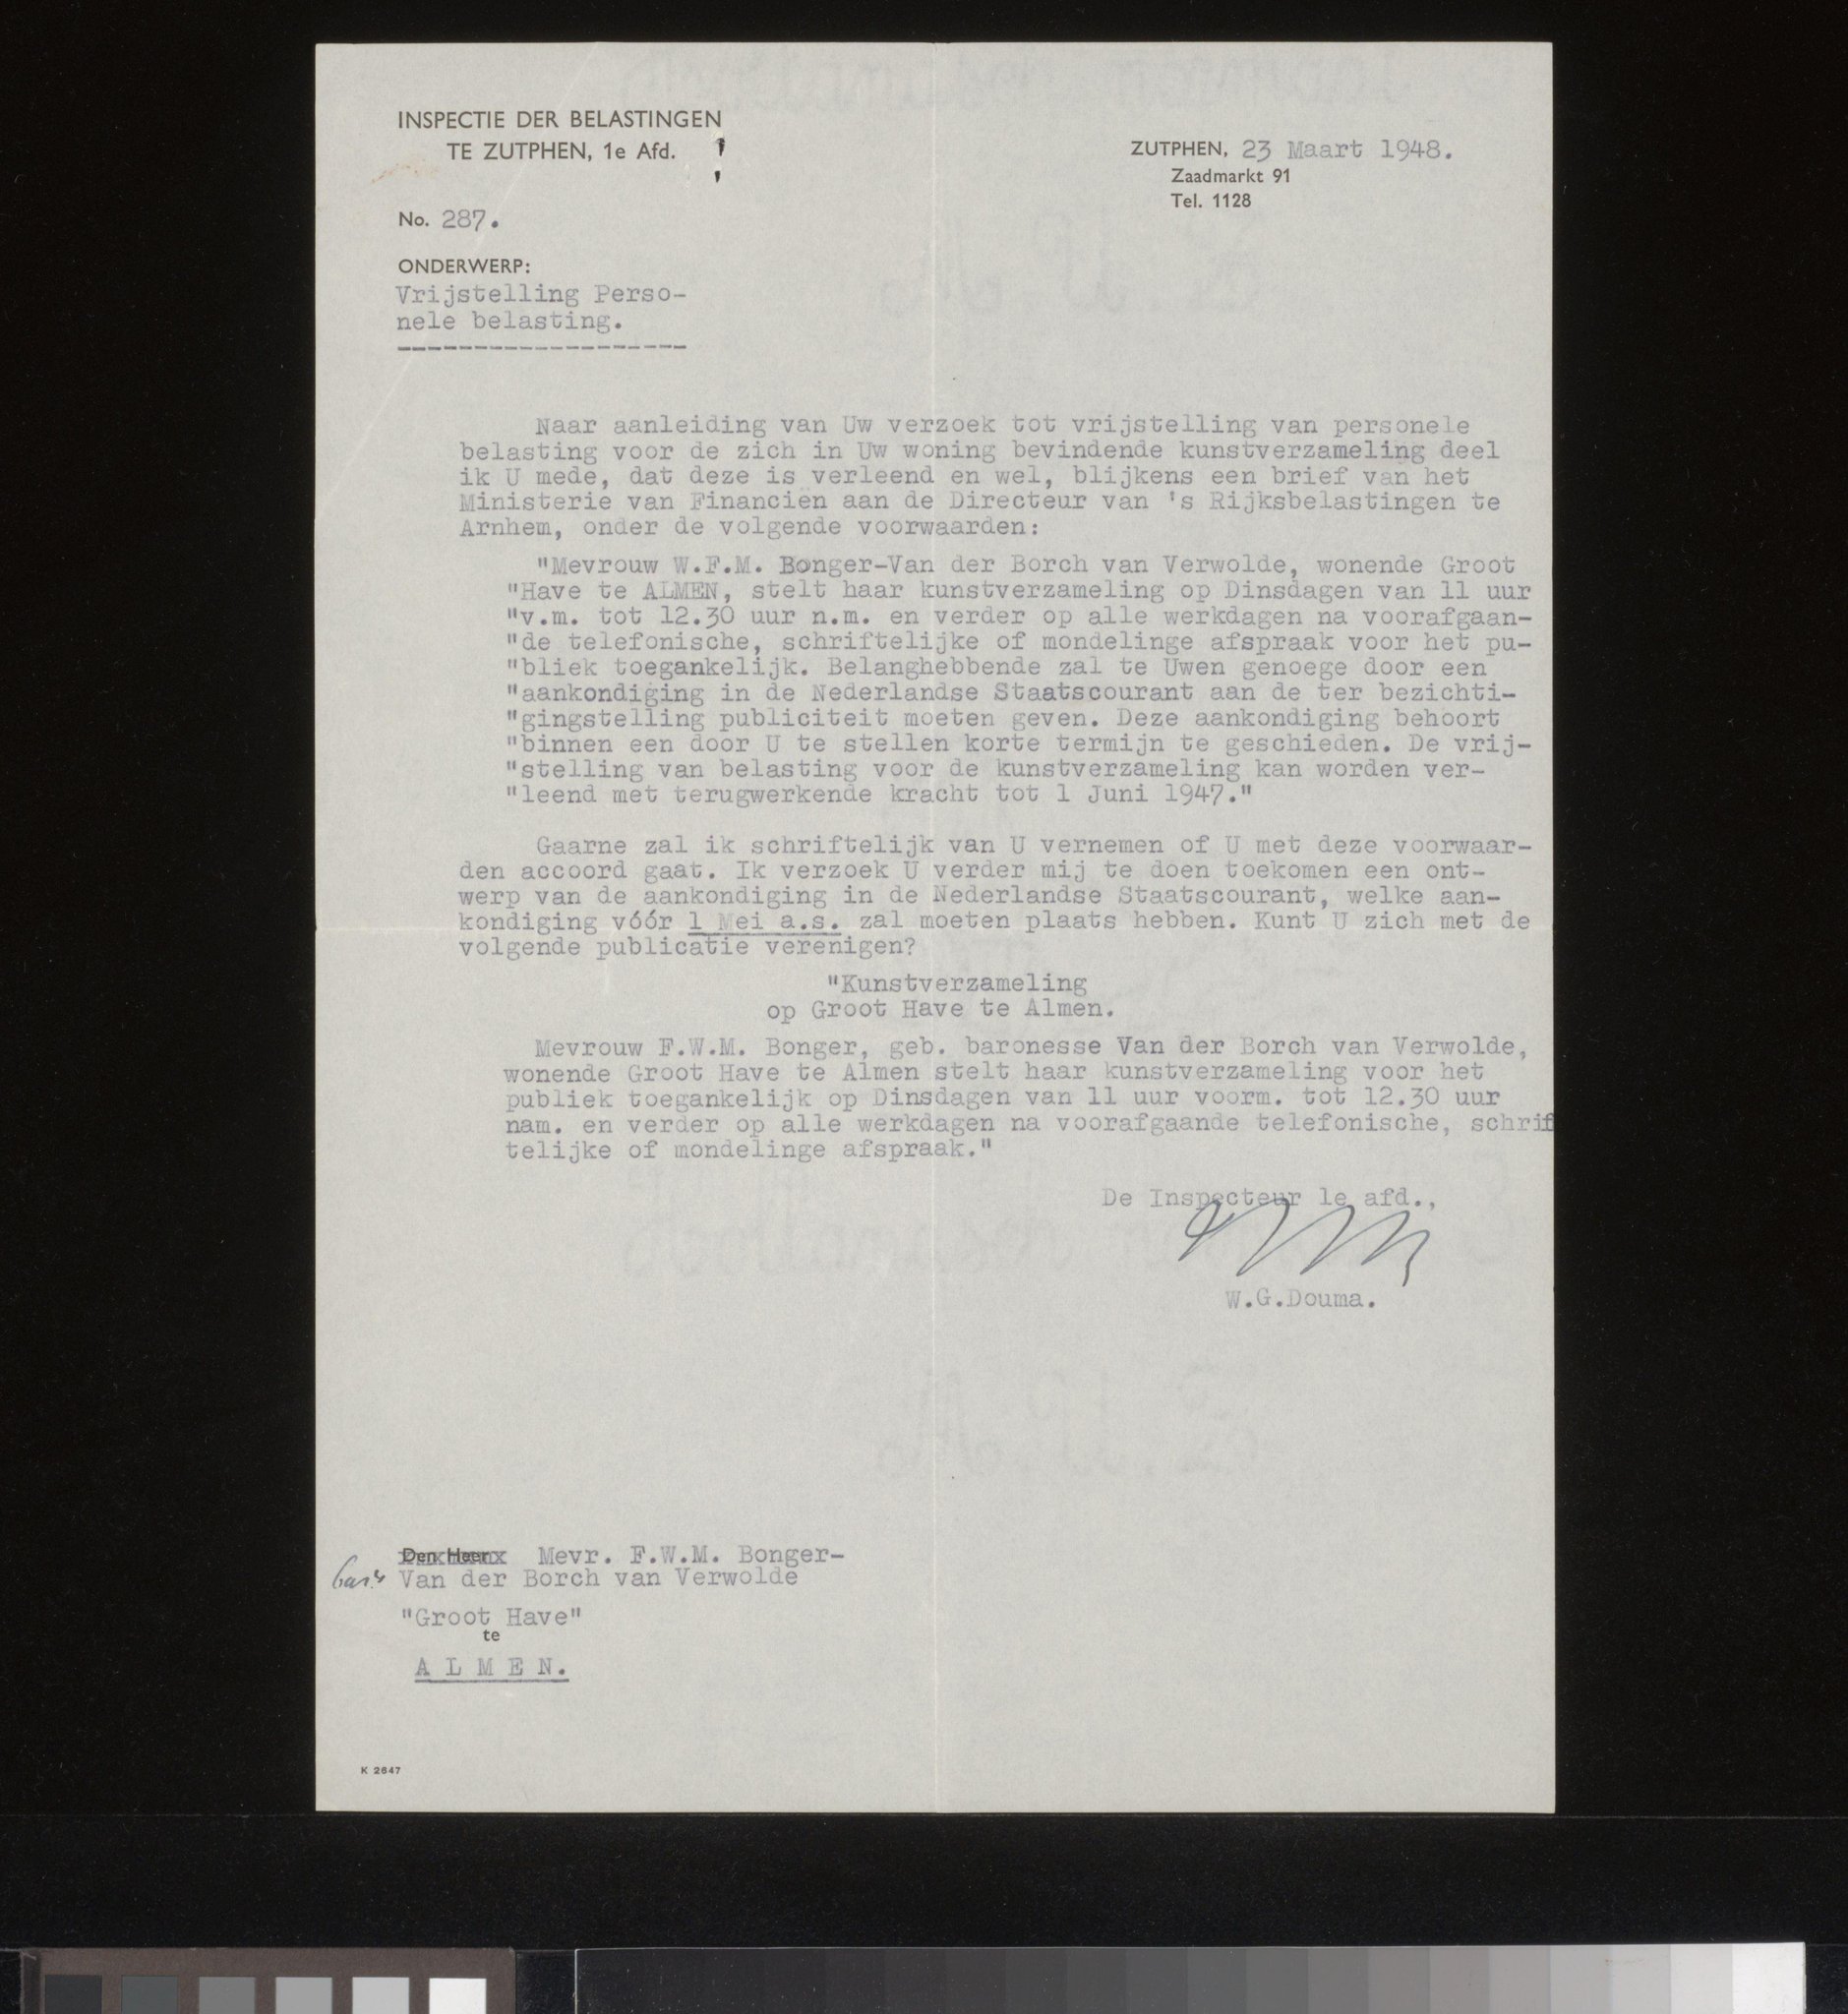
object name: letter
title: Brief aan Françoise W.M. Bonger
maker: w.g. douma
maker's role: inspecteur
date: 1948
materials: ink, paper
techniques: pen, printing, typewriting, writing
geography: zutphen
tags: françoise w.m. bonger, money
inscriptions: watermark